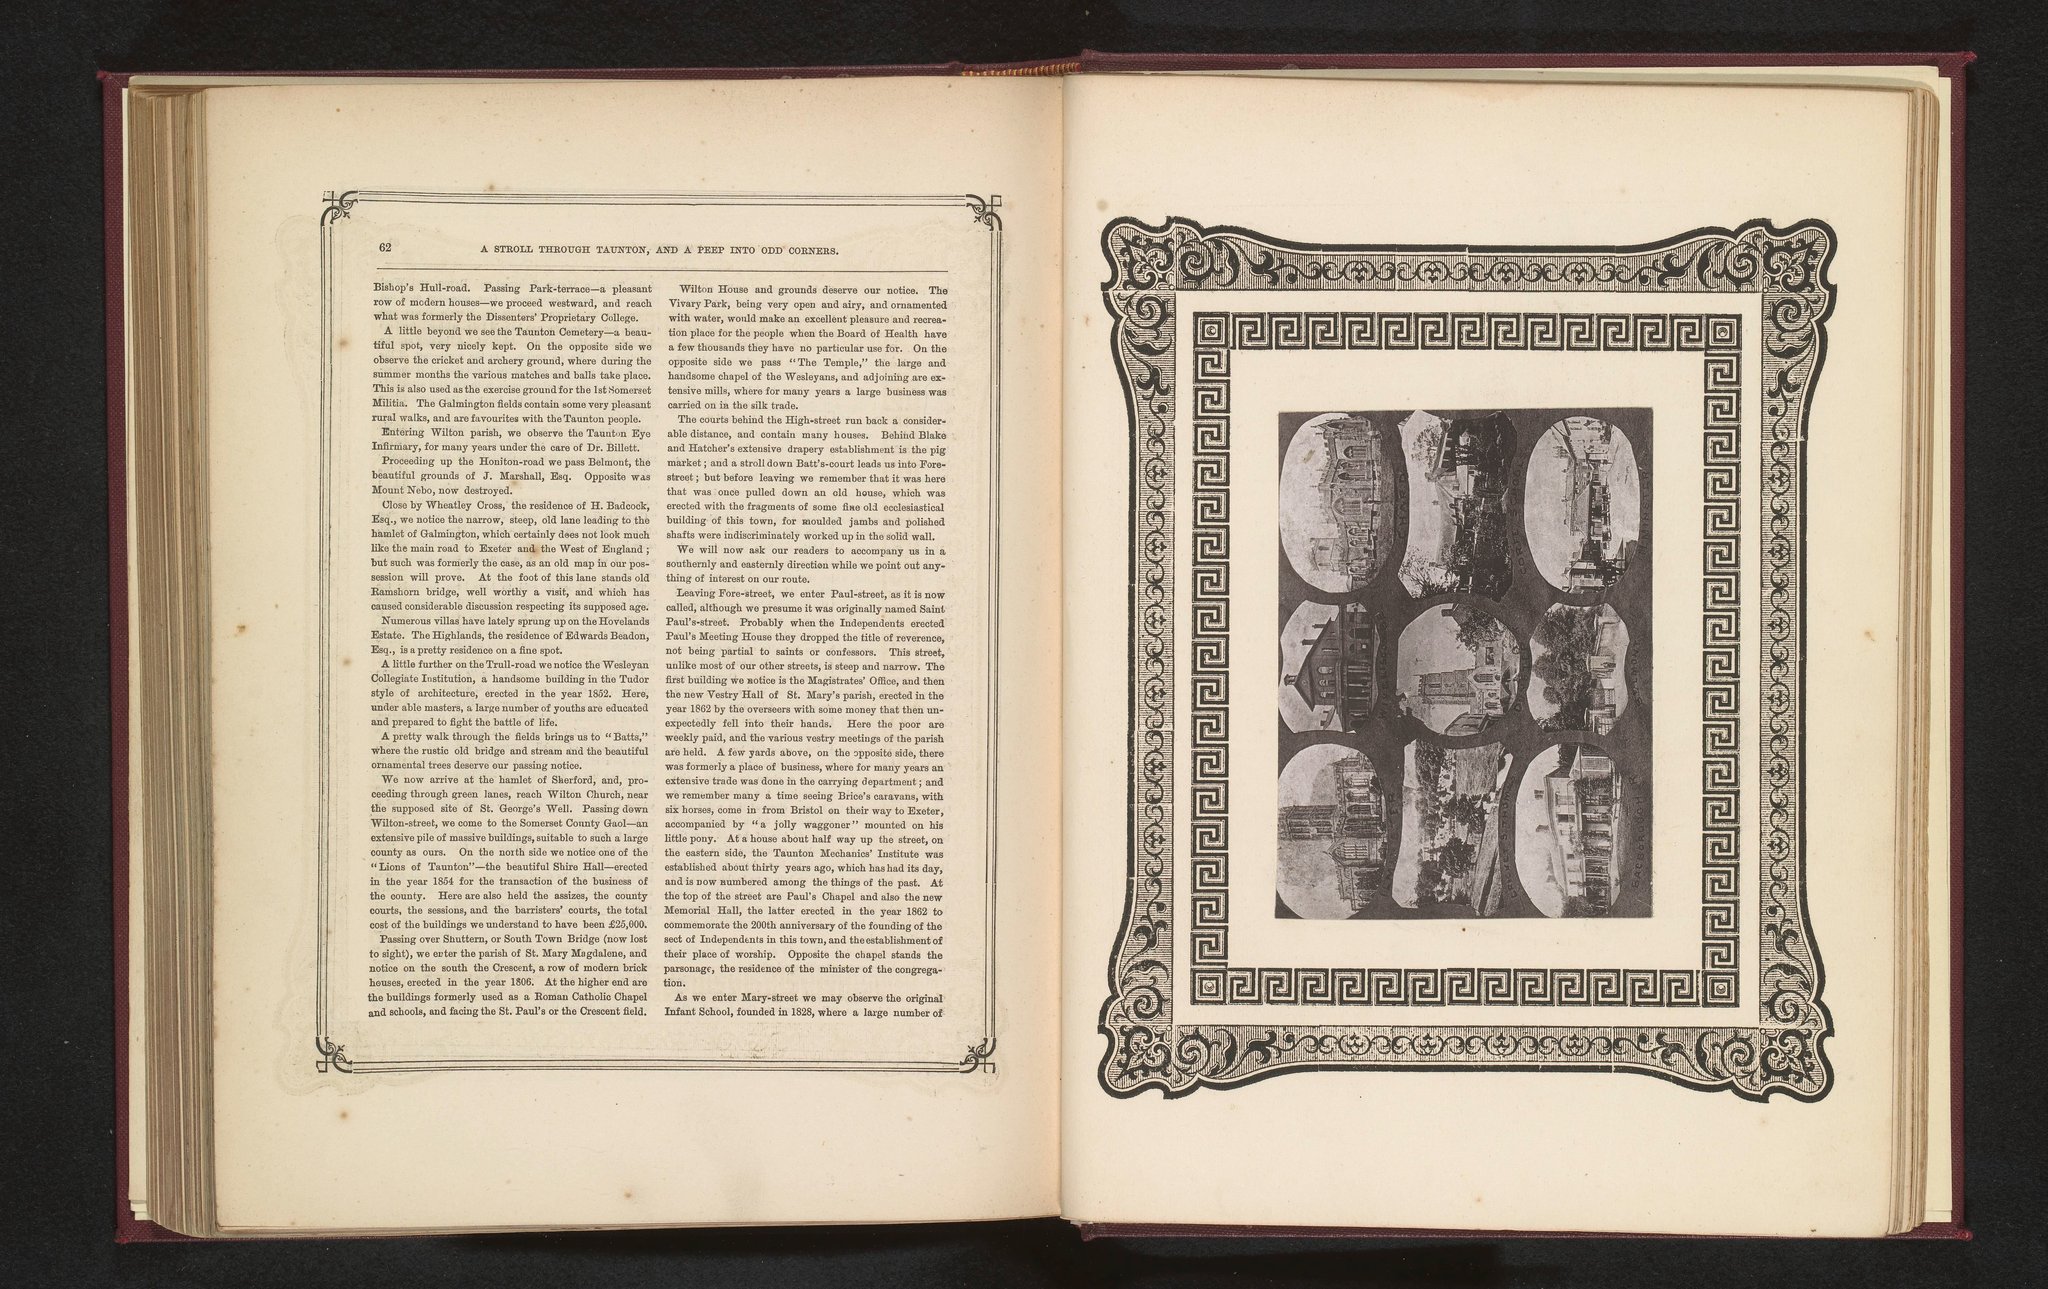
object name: photomontage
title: Negen gezichten op gebouwen in West Dorset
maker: Anonymous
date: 1868-1873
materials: paper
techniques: photoaquatint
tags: church (exterior), exterior ~ representation of a building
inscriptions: inscription: ‘Ilminster (...) Ilminster’